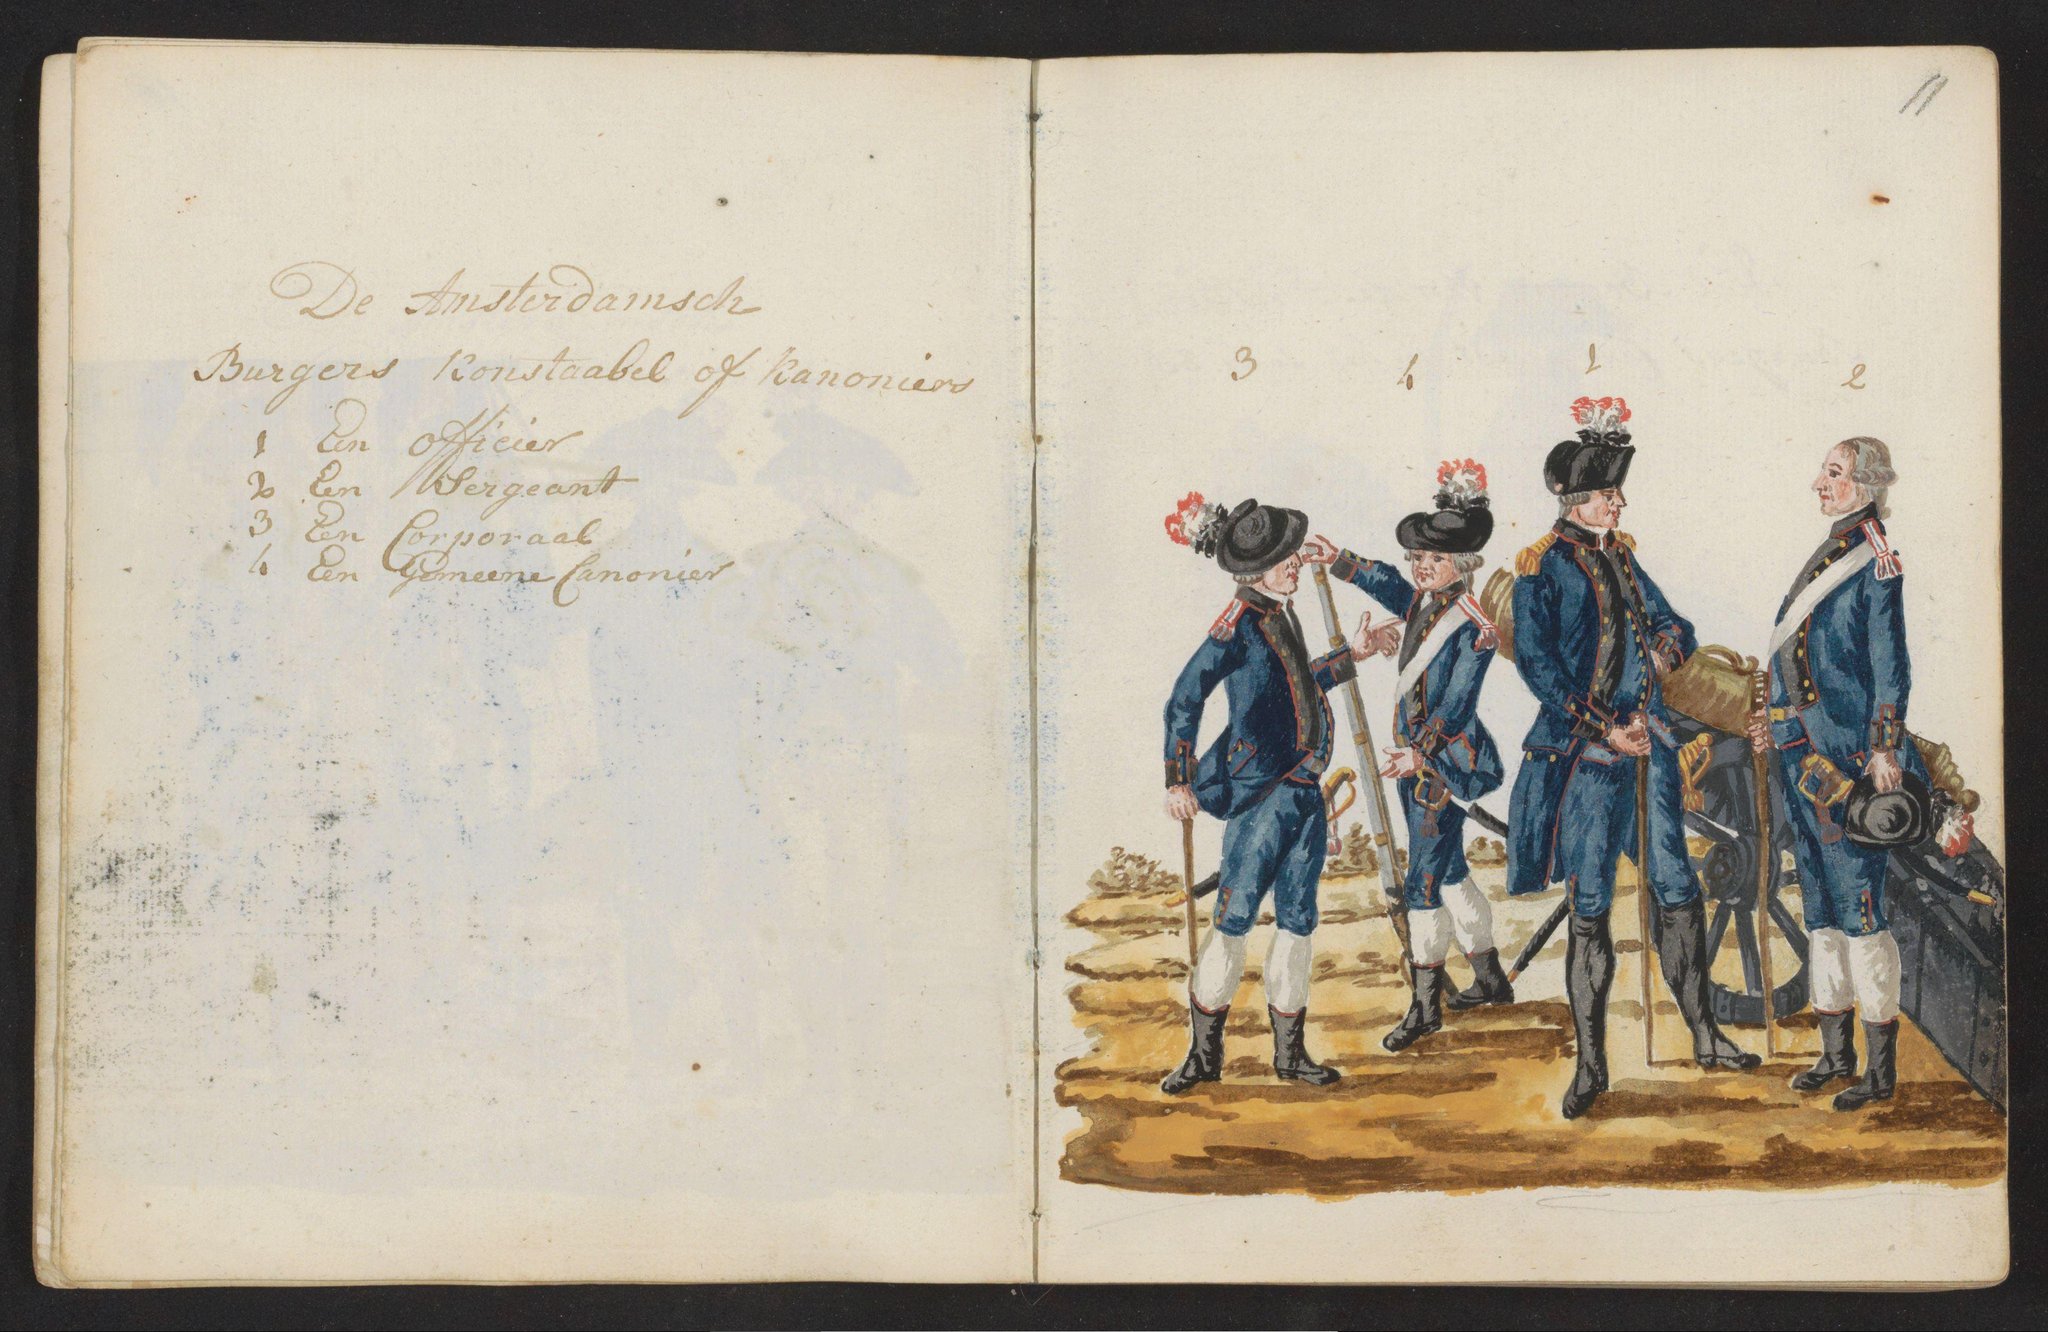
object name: drawing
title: De Amsterdamsch Burgers Konstaabel of kanoniers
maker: s.g. casten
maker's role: draughtsman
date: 1795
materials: paper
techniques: writing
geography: amsterdam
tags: (military) uniforms (+ citizen soldiery, civil guard, citizen militia), patriots (1780-1795)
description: De uniformen van konstabels of kanonniers van het Amsterdamse exercitiegenootschap. Onderdeel van het tweede hoofdstuk over de nieuwe Amsterdamse schutterij tussen 1783-1787. In het schetsboek met gekleurde tekeningen van de uniformen van militairen en leden van de schutterij uit de periode 1770 tot 1795-1796.